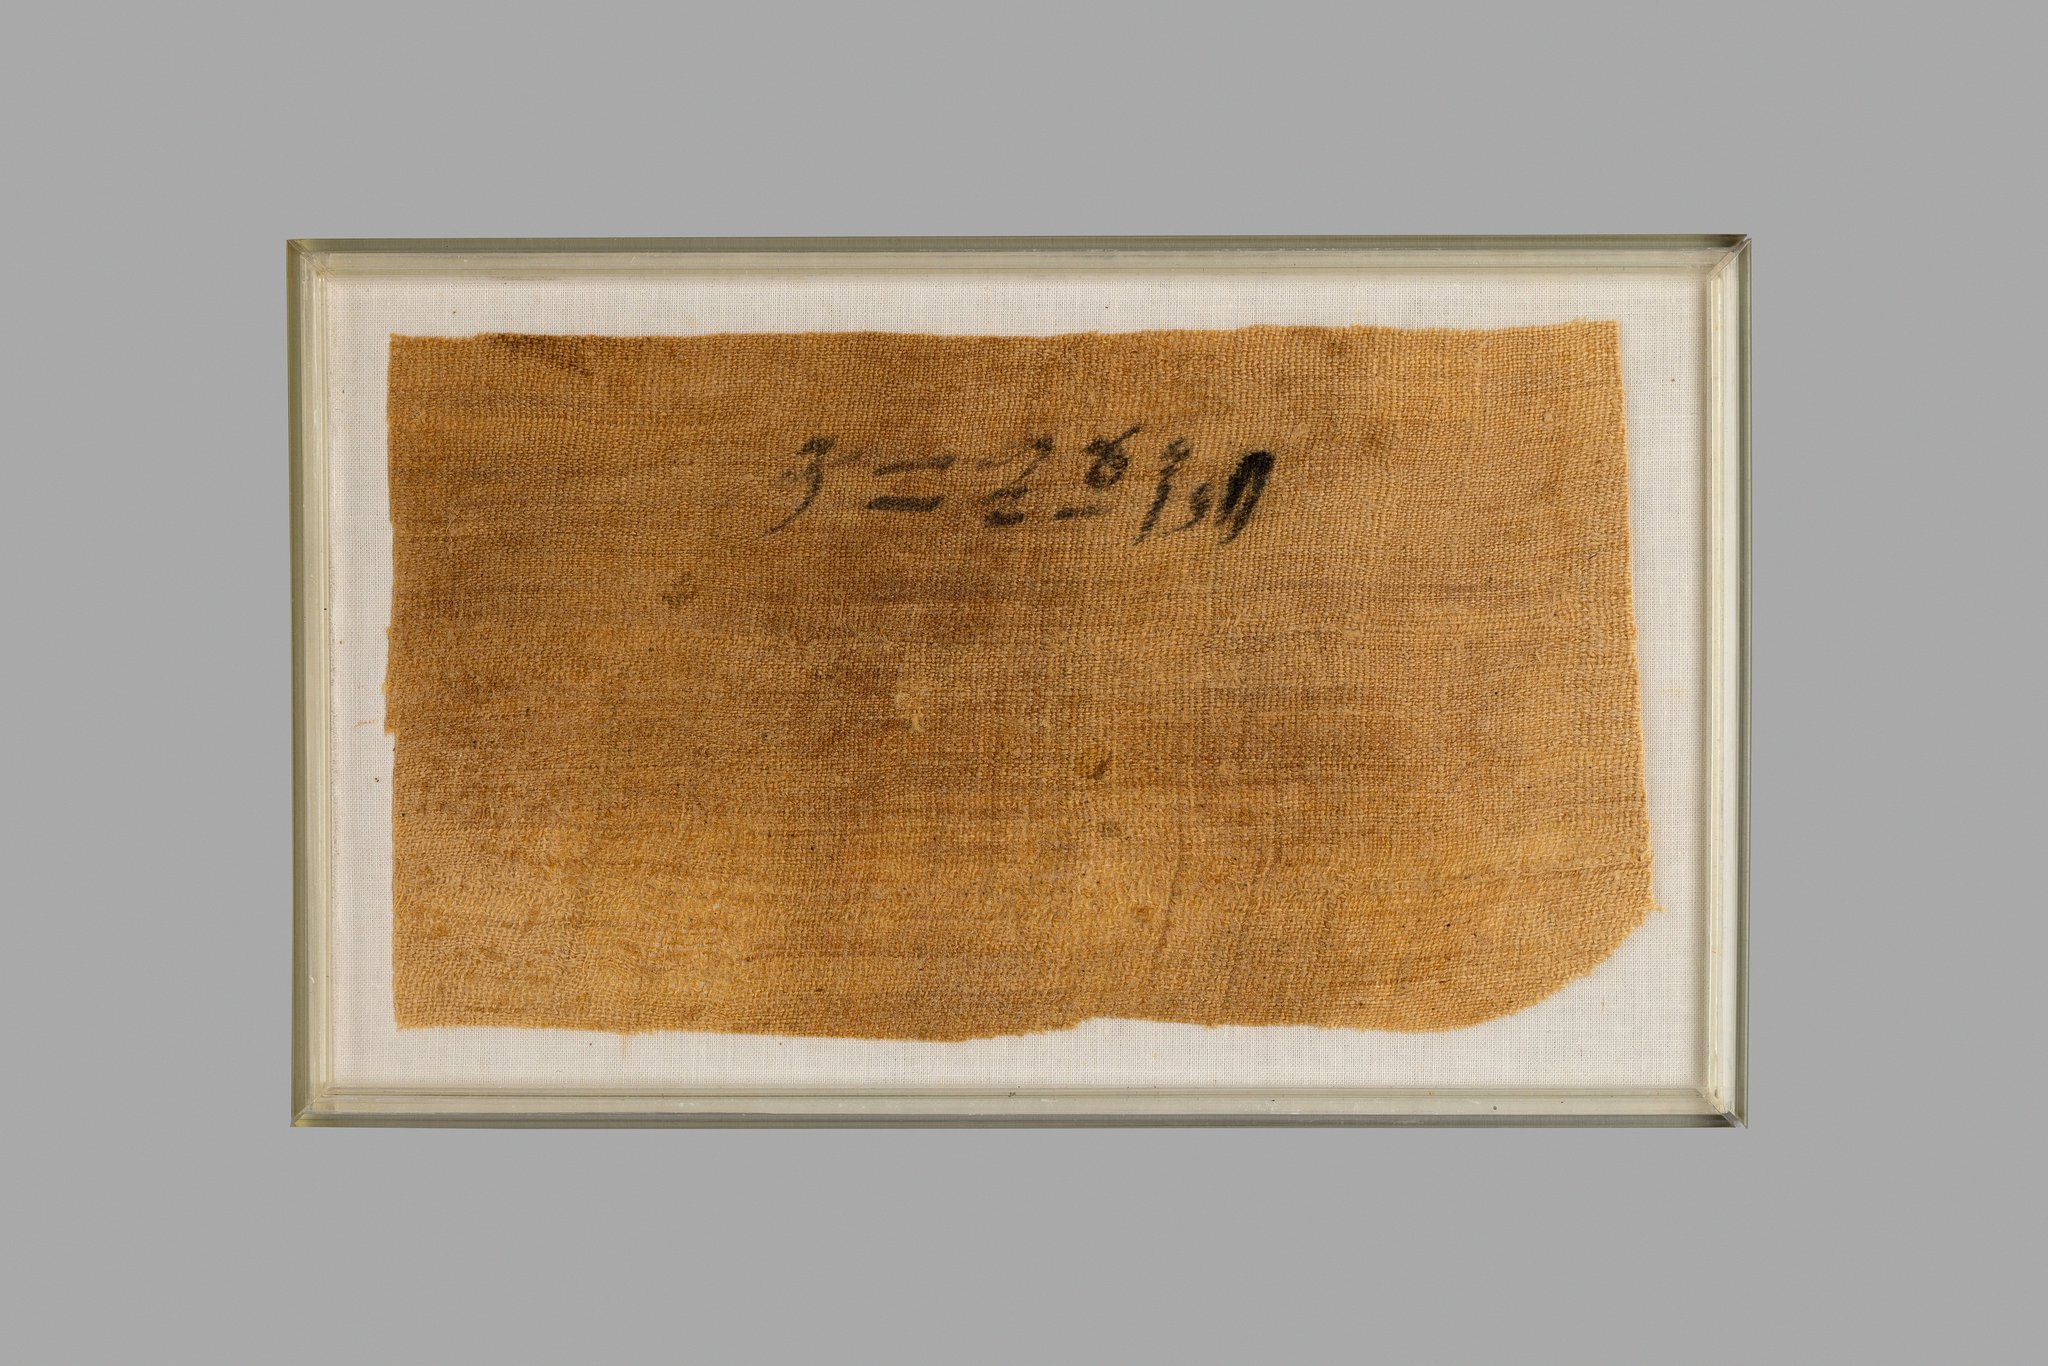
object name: linen mark, embalmer's docket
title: Embalmers' Dockets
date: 1479-1458 BCE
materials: ink, linen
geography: egypt